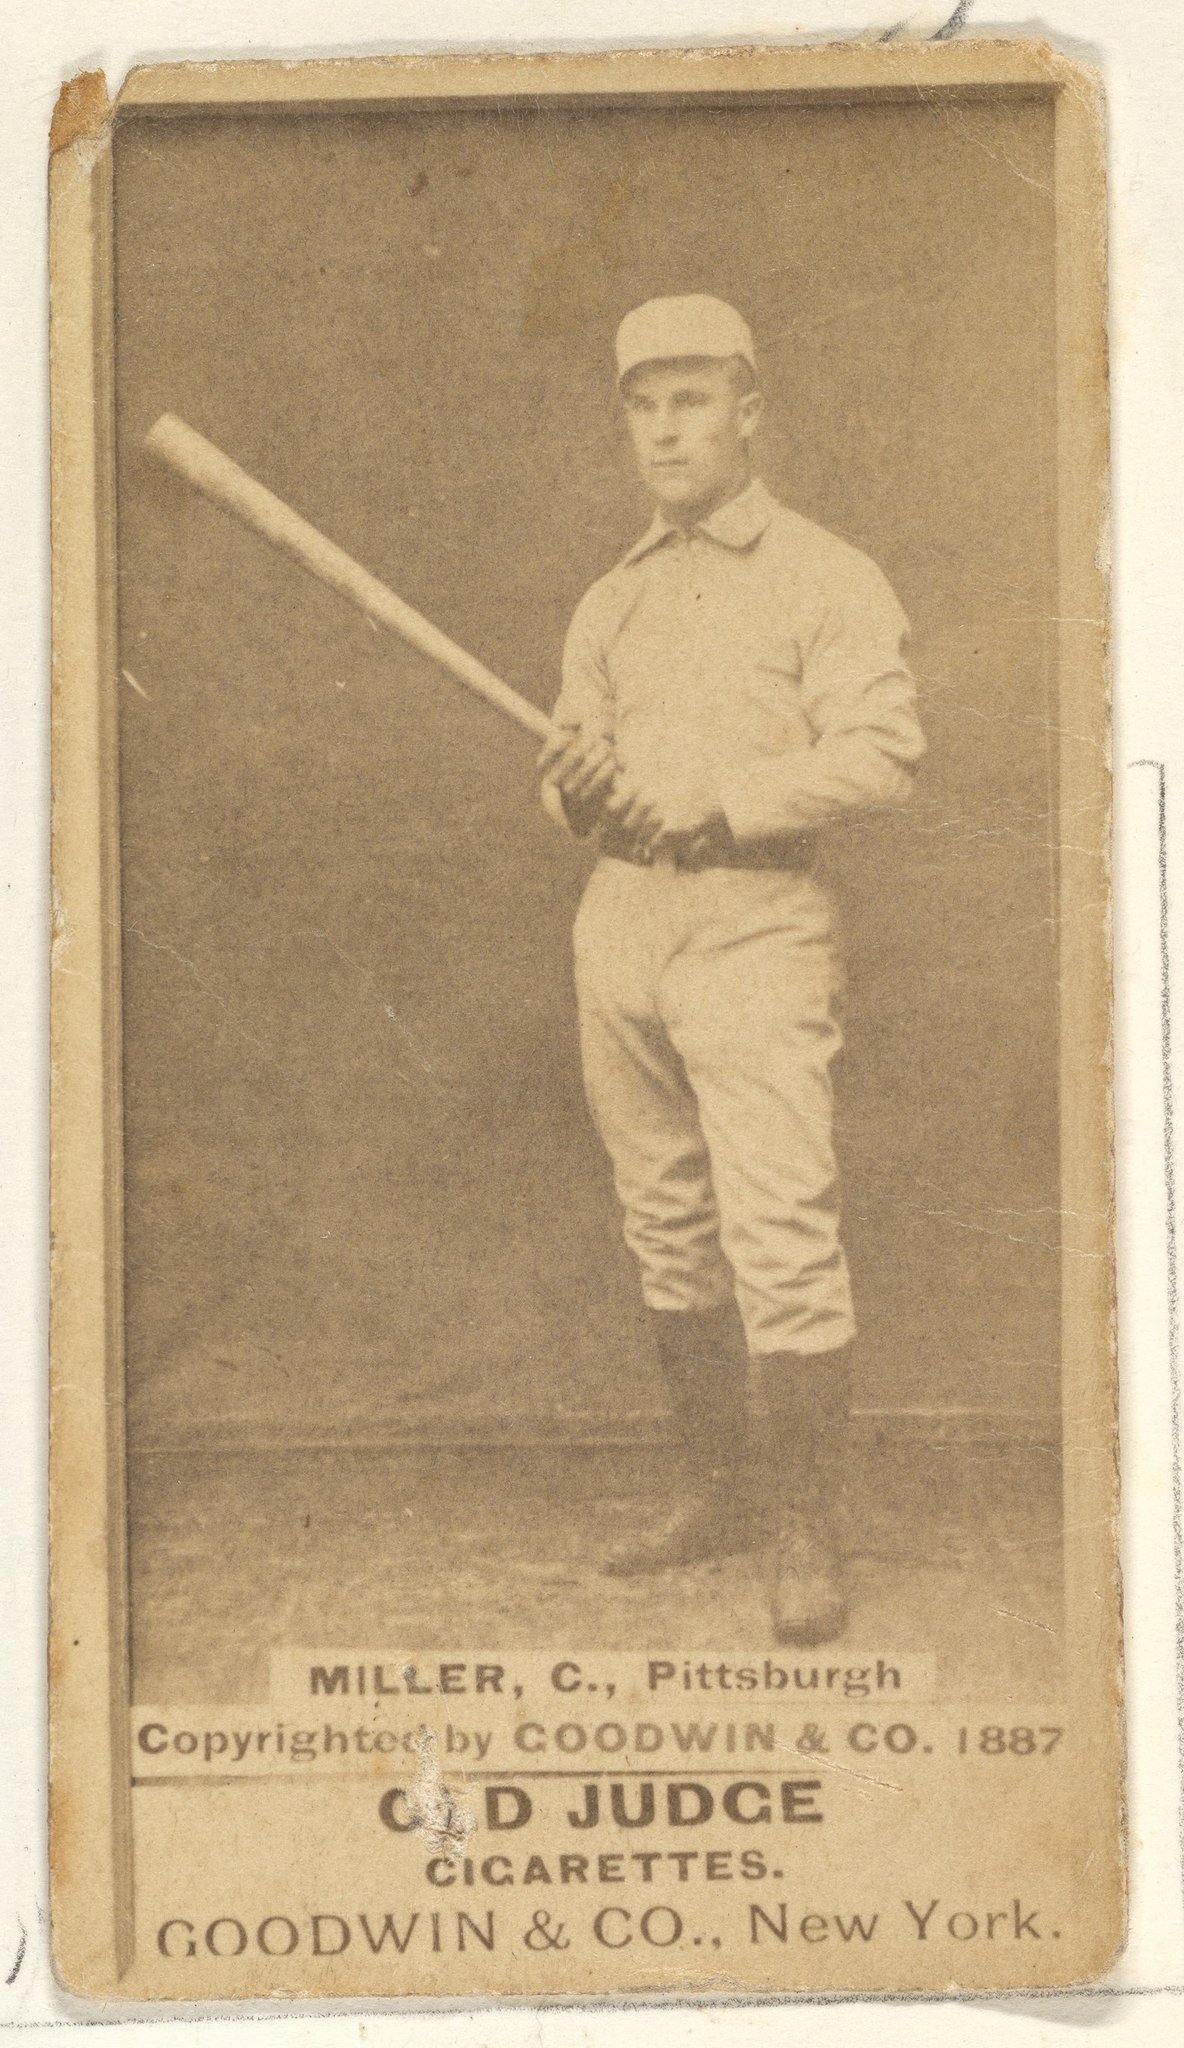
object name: baseball card, photograph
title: George Frederick "Doggie" Miller, Catcher, Pittsburgh, from the Old Judge series (N172) for Old Judge Cigarettes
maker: goodwin & company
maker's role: publisher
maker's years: 1850-1950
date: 1887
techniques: albumen silver print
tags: men,portraits,baseball,athletes